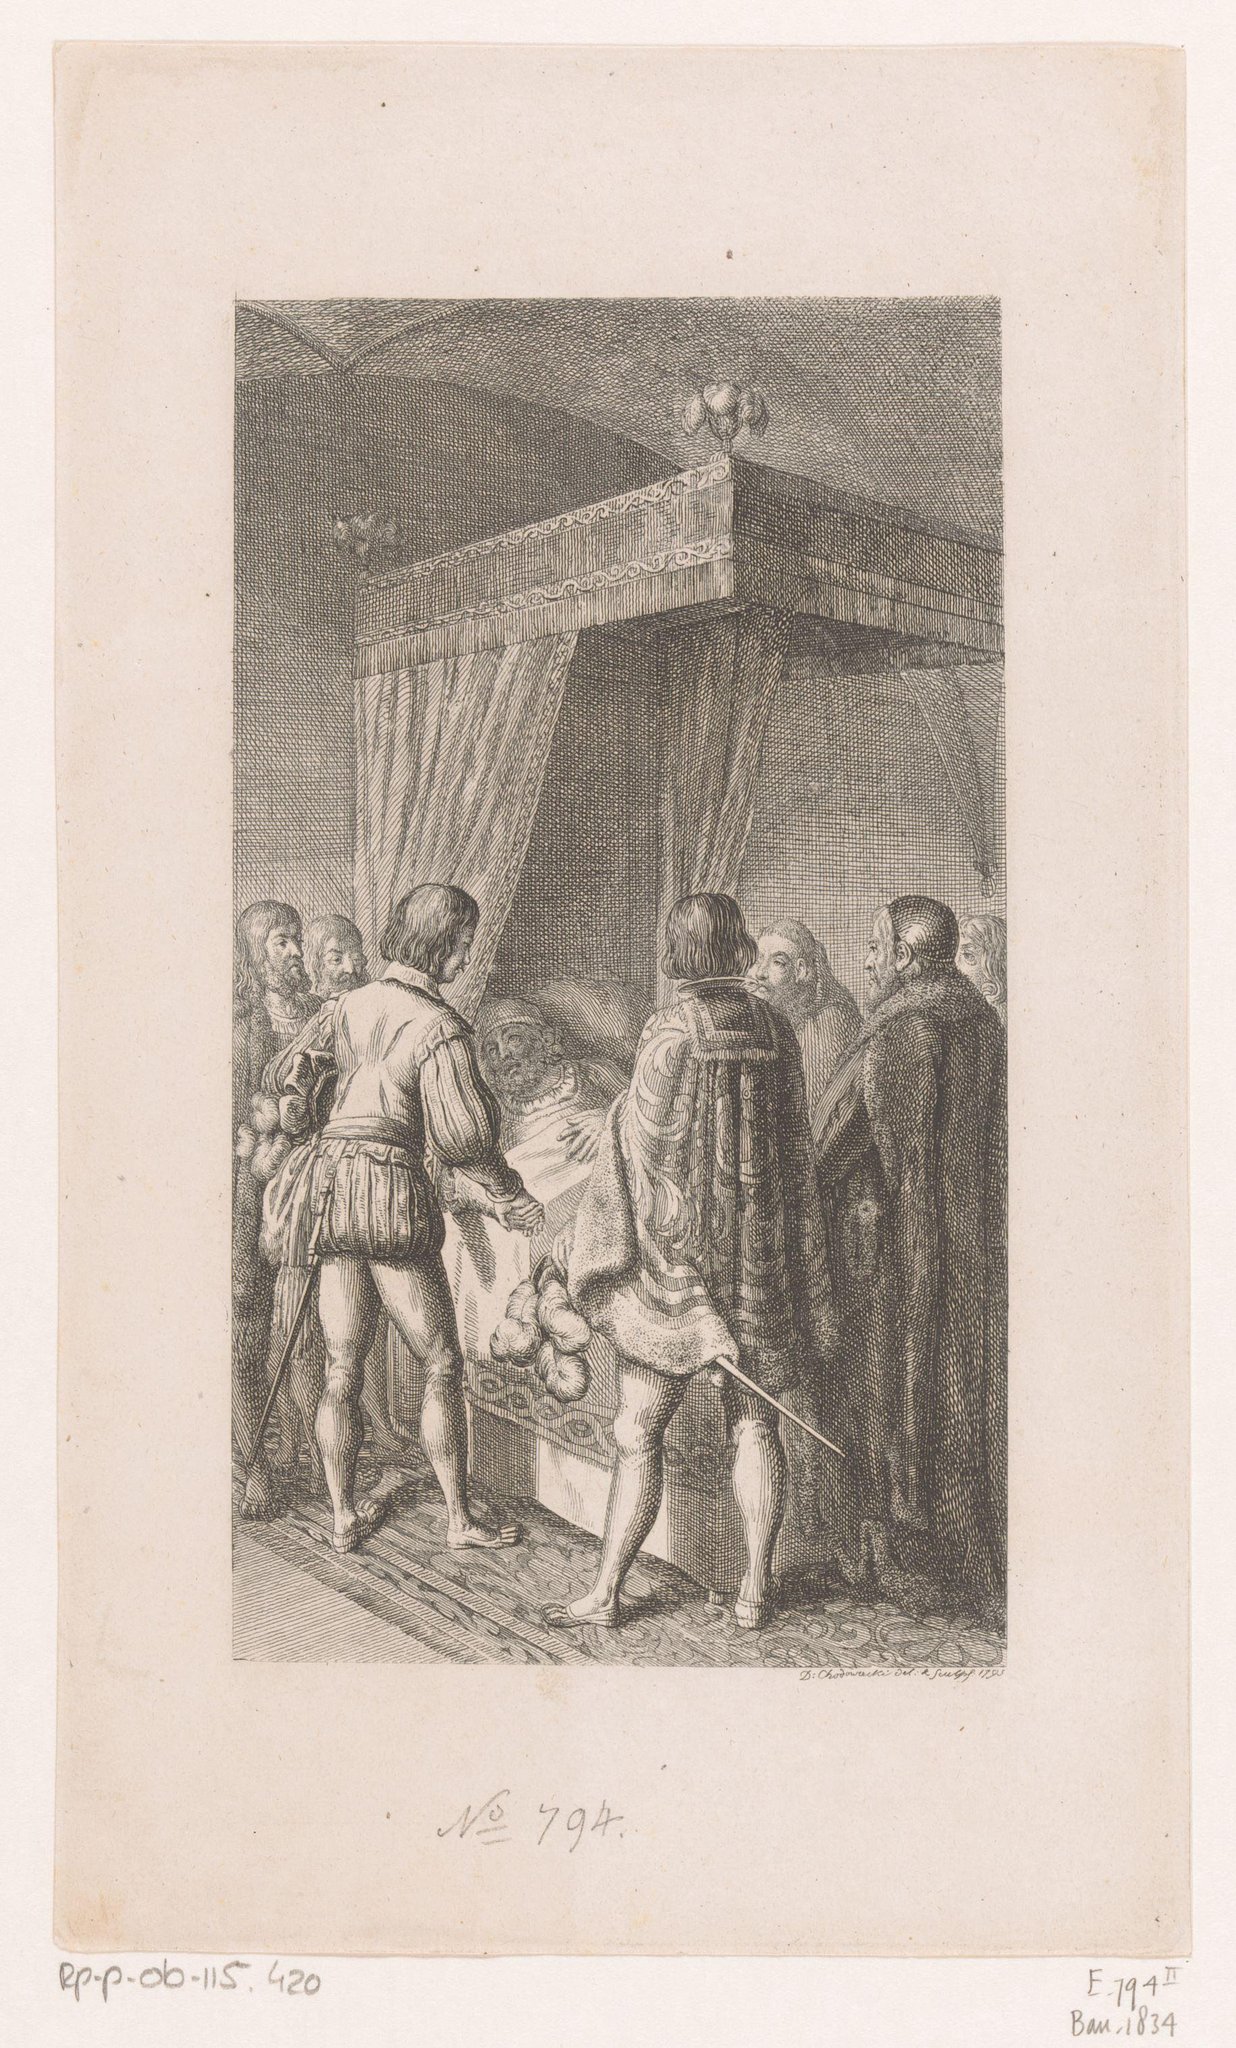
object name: print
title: Otto II van Beieren op zijn sterfbed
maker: daniel nikolaus chodowiecki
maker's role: draughtsman, print maker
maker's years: 1726-1801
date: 1795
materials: paper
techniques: etching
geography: berlin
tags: history, deathbed, ruler, sovereign, father and son(s) (family group)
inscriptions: collector's mark: Lugt 2228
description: Prent gebruikt voor: Deutsche Monatsschrift (...). 3 dln. Leipzig: Sommersche Buchhandlung, 1795.